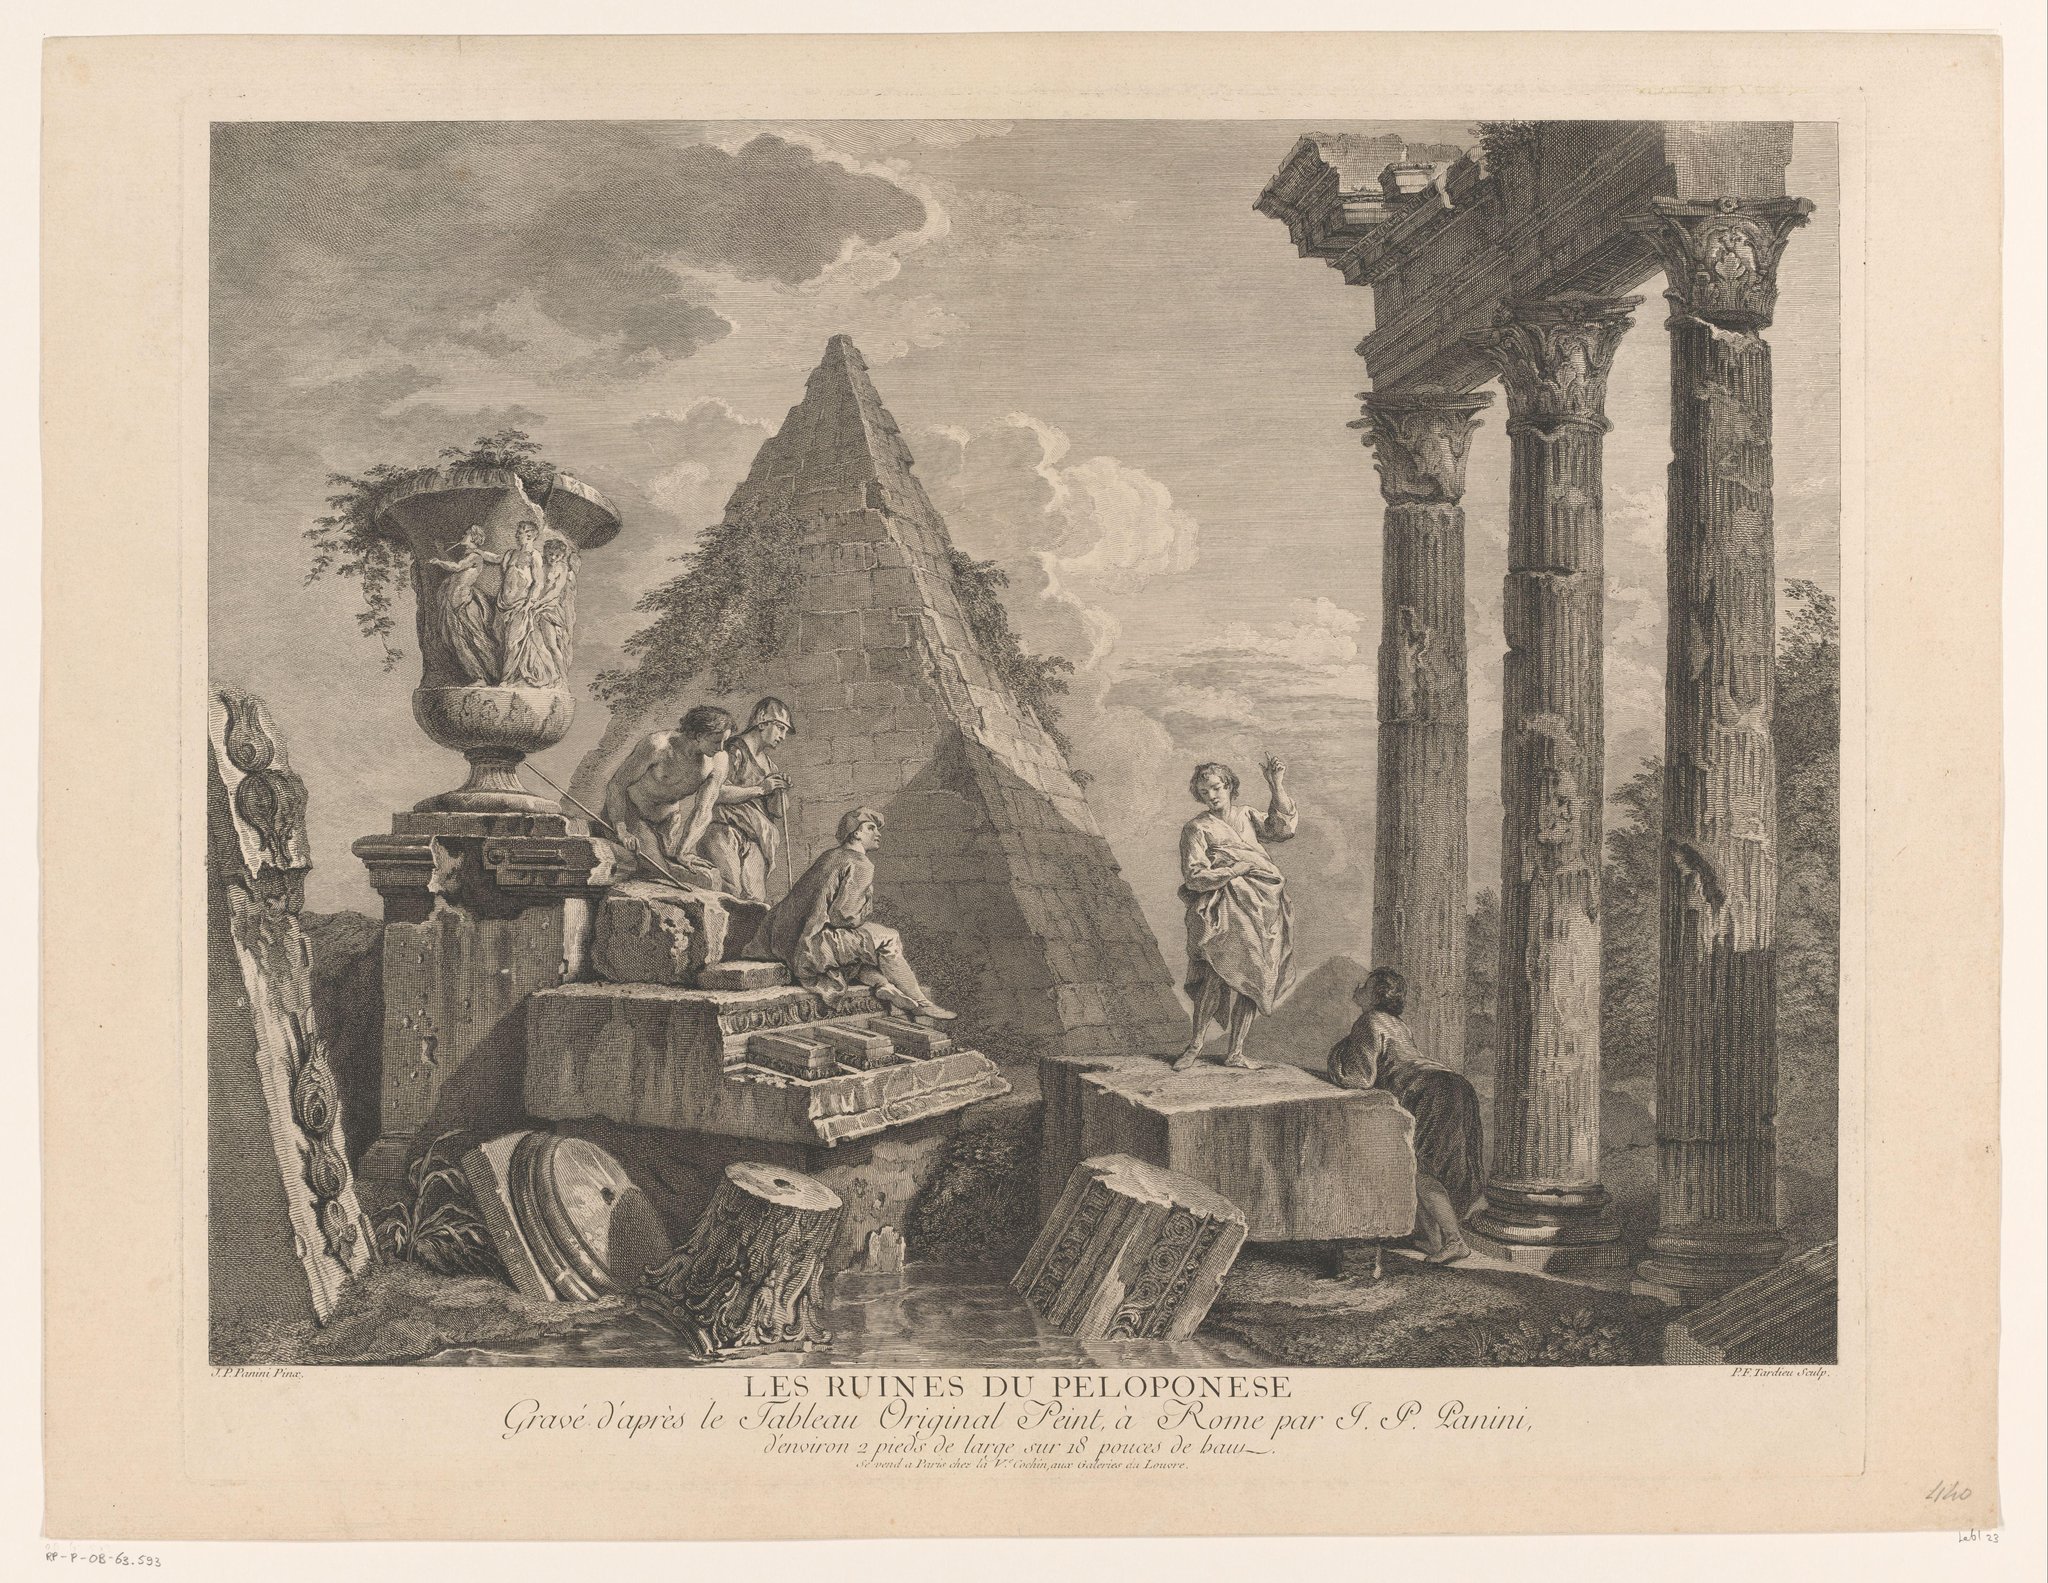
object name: print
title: Ruïne op Peloponnesos met figuren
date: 1754-1771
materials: paper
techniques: engraving, etching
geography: paris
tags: ruin of a building ~ architecture, pyramid (historical grave form)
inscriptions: collector's mark: Lugt 240